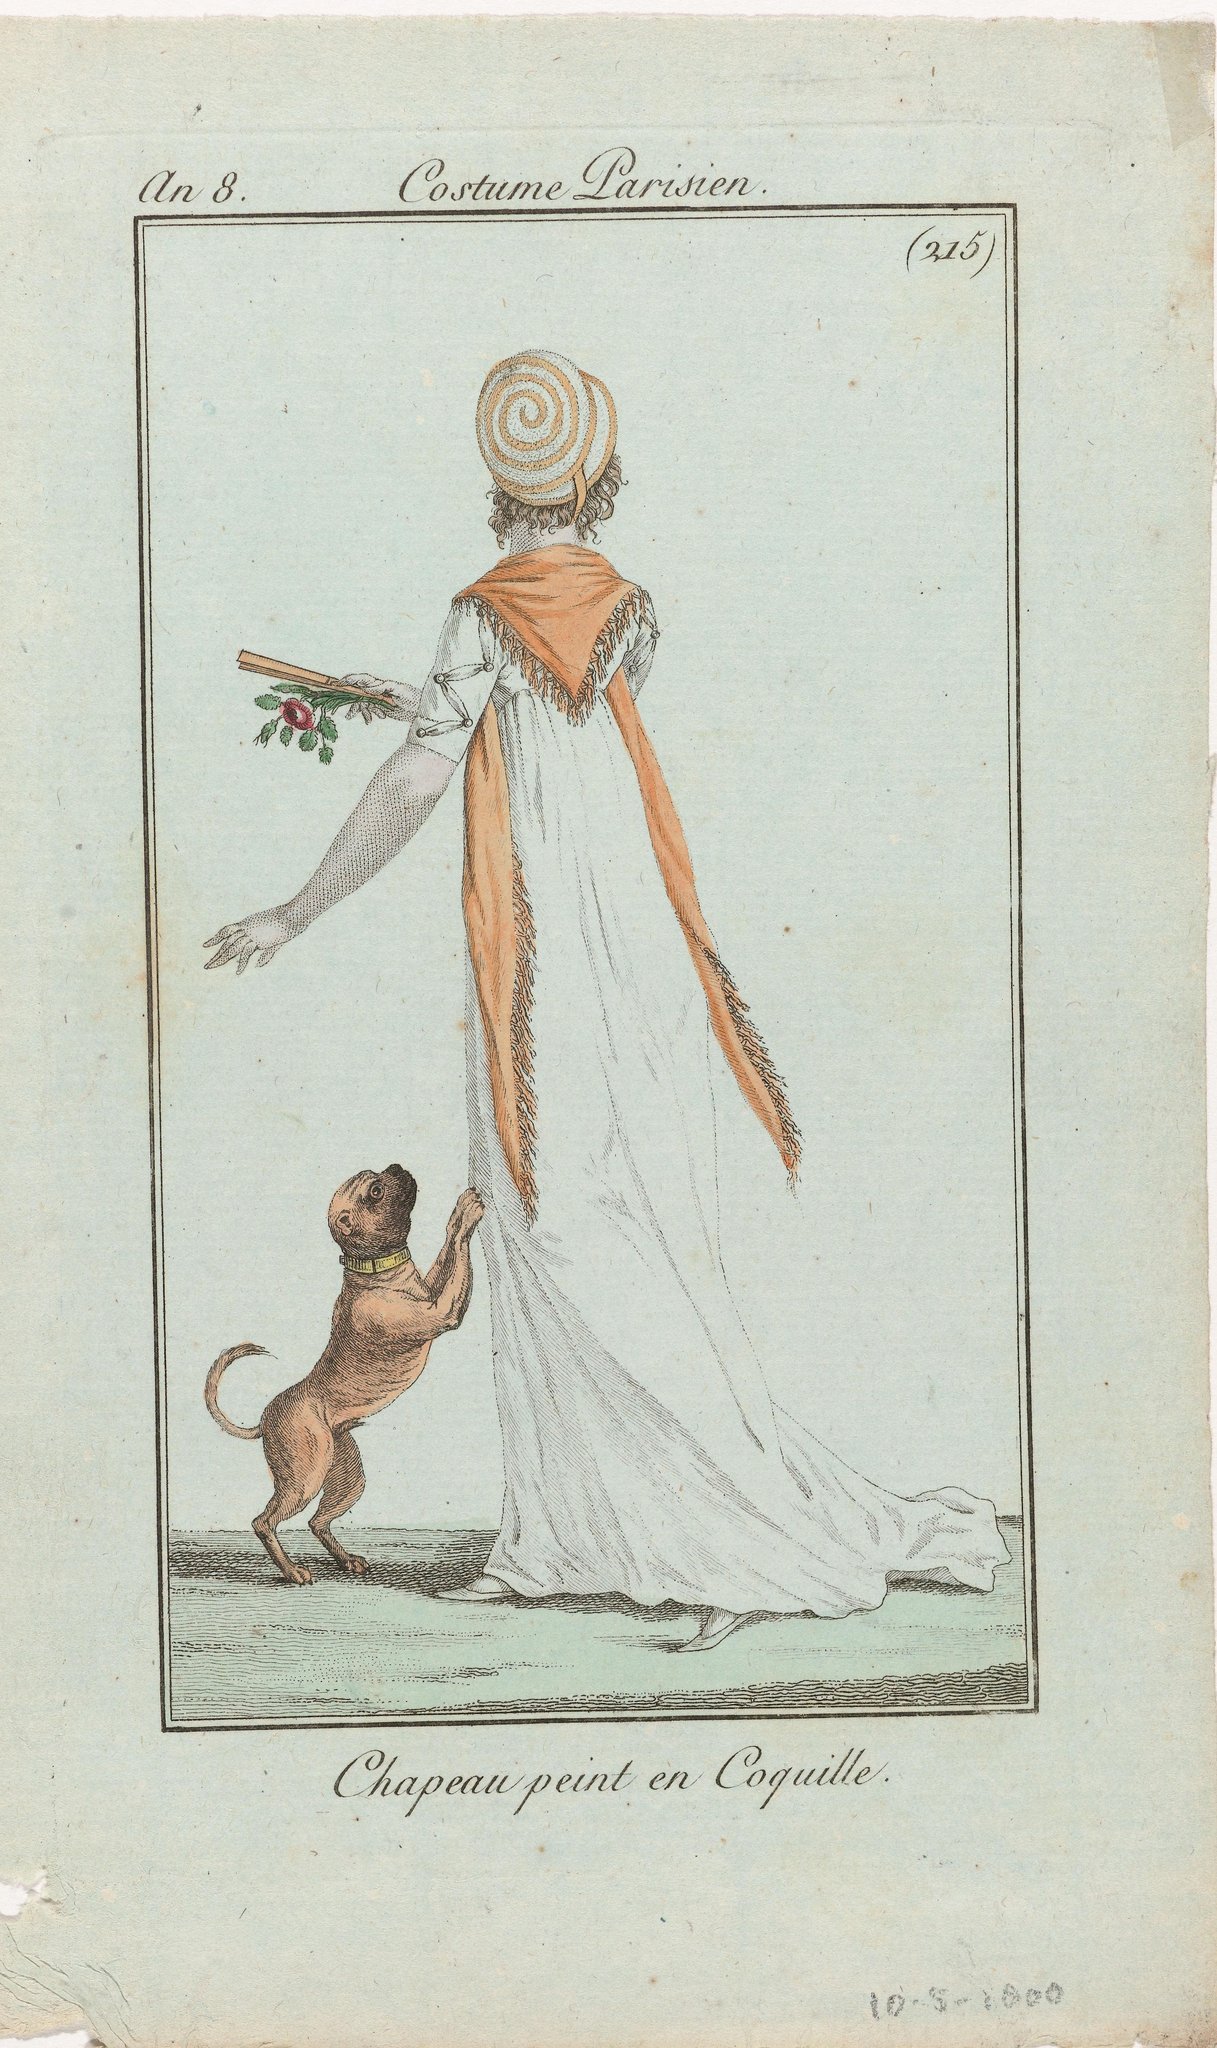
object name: fashion print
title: Journal des Dames et des Modes, Costume Parisien, 10 mai 1800, An 8, (215) : Chapeau peint en Coquille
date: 1800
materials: paper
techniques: engraving, hand coloring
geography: paris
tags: cut flowers; nosegay, bunch of flowers, clothing for the upper part of the body (shawl) (+ women's clothes), fashion plates, head-gear: hat (+ women's clothes), shoes, sandals (+ women's clothes), dress, gown (+ women's clothes), fan (+ women's clothes), collar (of a dog)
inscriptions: caption: ‘Chapeau peint en Coquille’, title: ‘Costume Parisien.’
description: Vrouw, op de rug gezien, met op het hoofd een beschilderde hoed: 'Chapeau peint en Coquille'. Zij draagt een japon met korte mouwen en sleep. Op de achterzijde van de mouw een zig-zag versiering. Verdere accessoires: om de schouders een sjaal afgezet met franjes, waaier, platte schoenen met puntige neuzen. In de rechterhand een bloem. Links een opspringend hondje met halsband. De prent maakt deel uit van het modetijdschrift Journal des Dames et des Modes, uitgegeven door Pierre de la Mésangère, Parijs, 1797-1839.